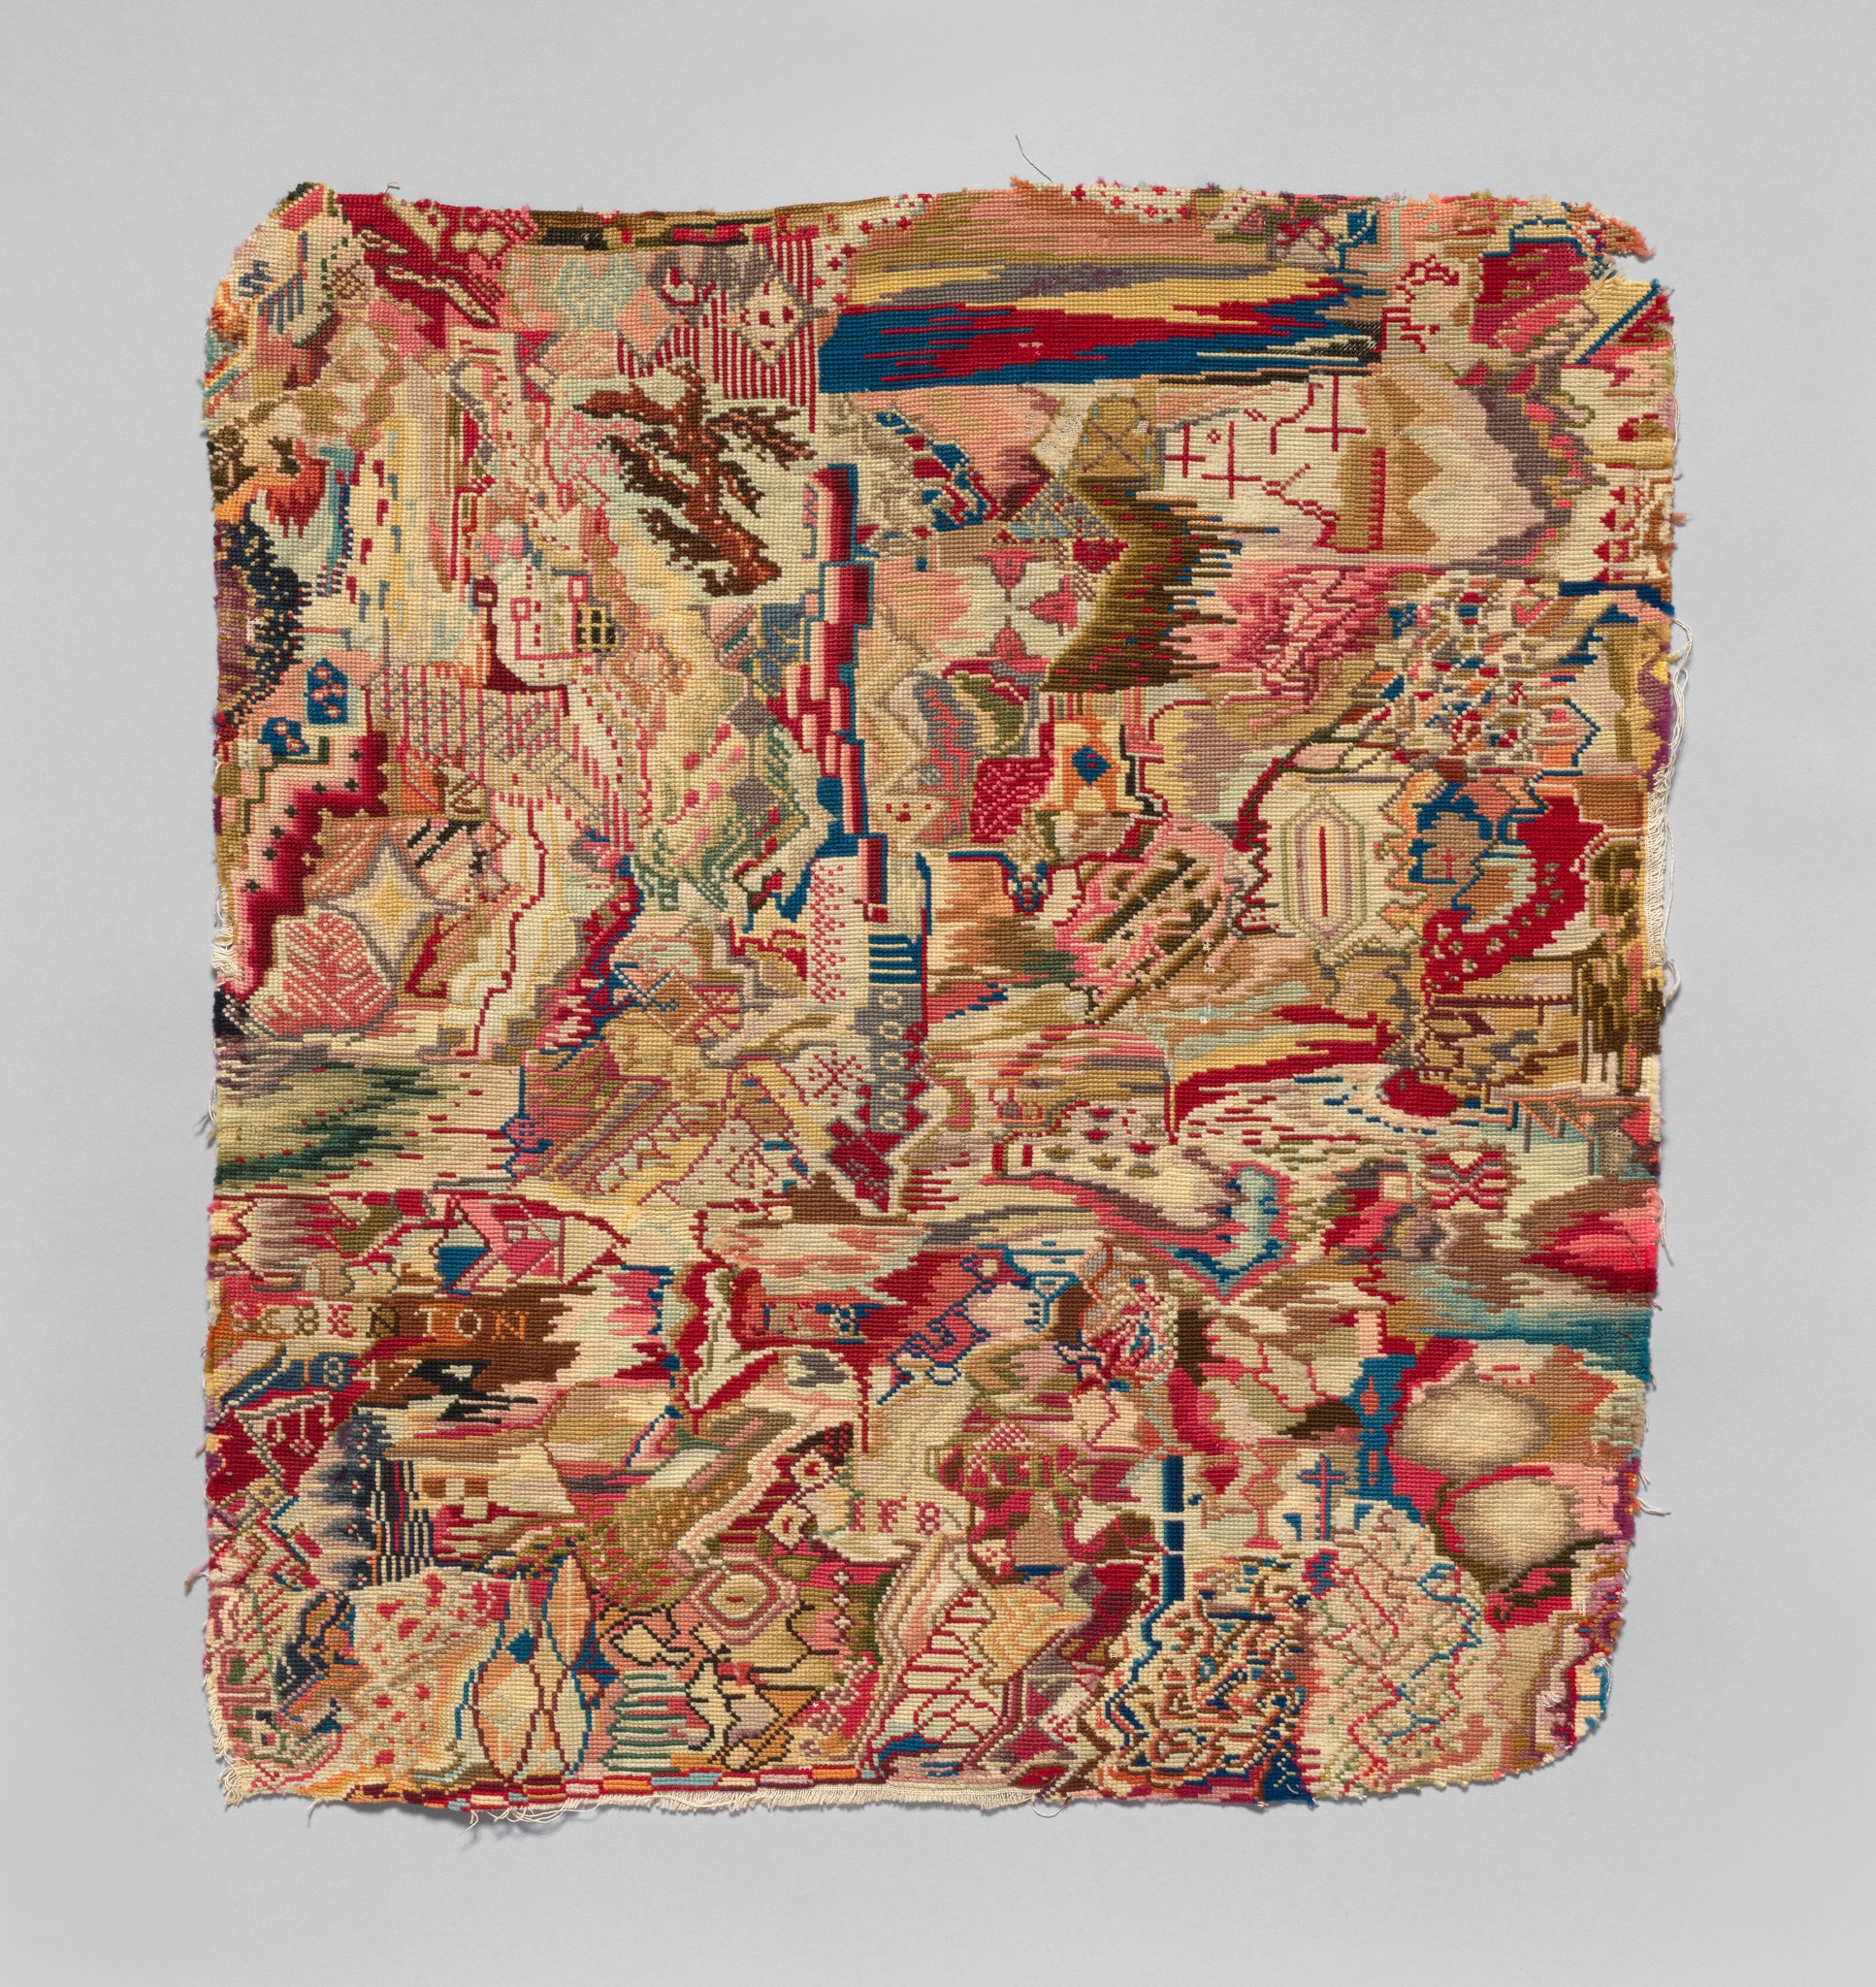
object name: piece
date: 1847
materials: linen, wool